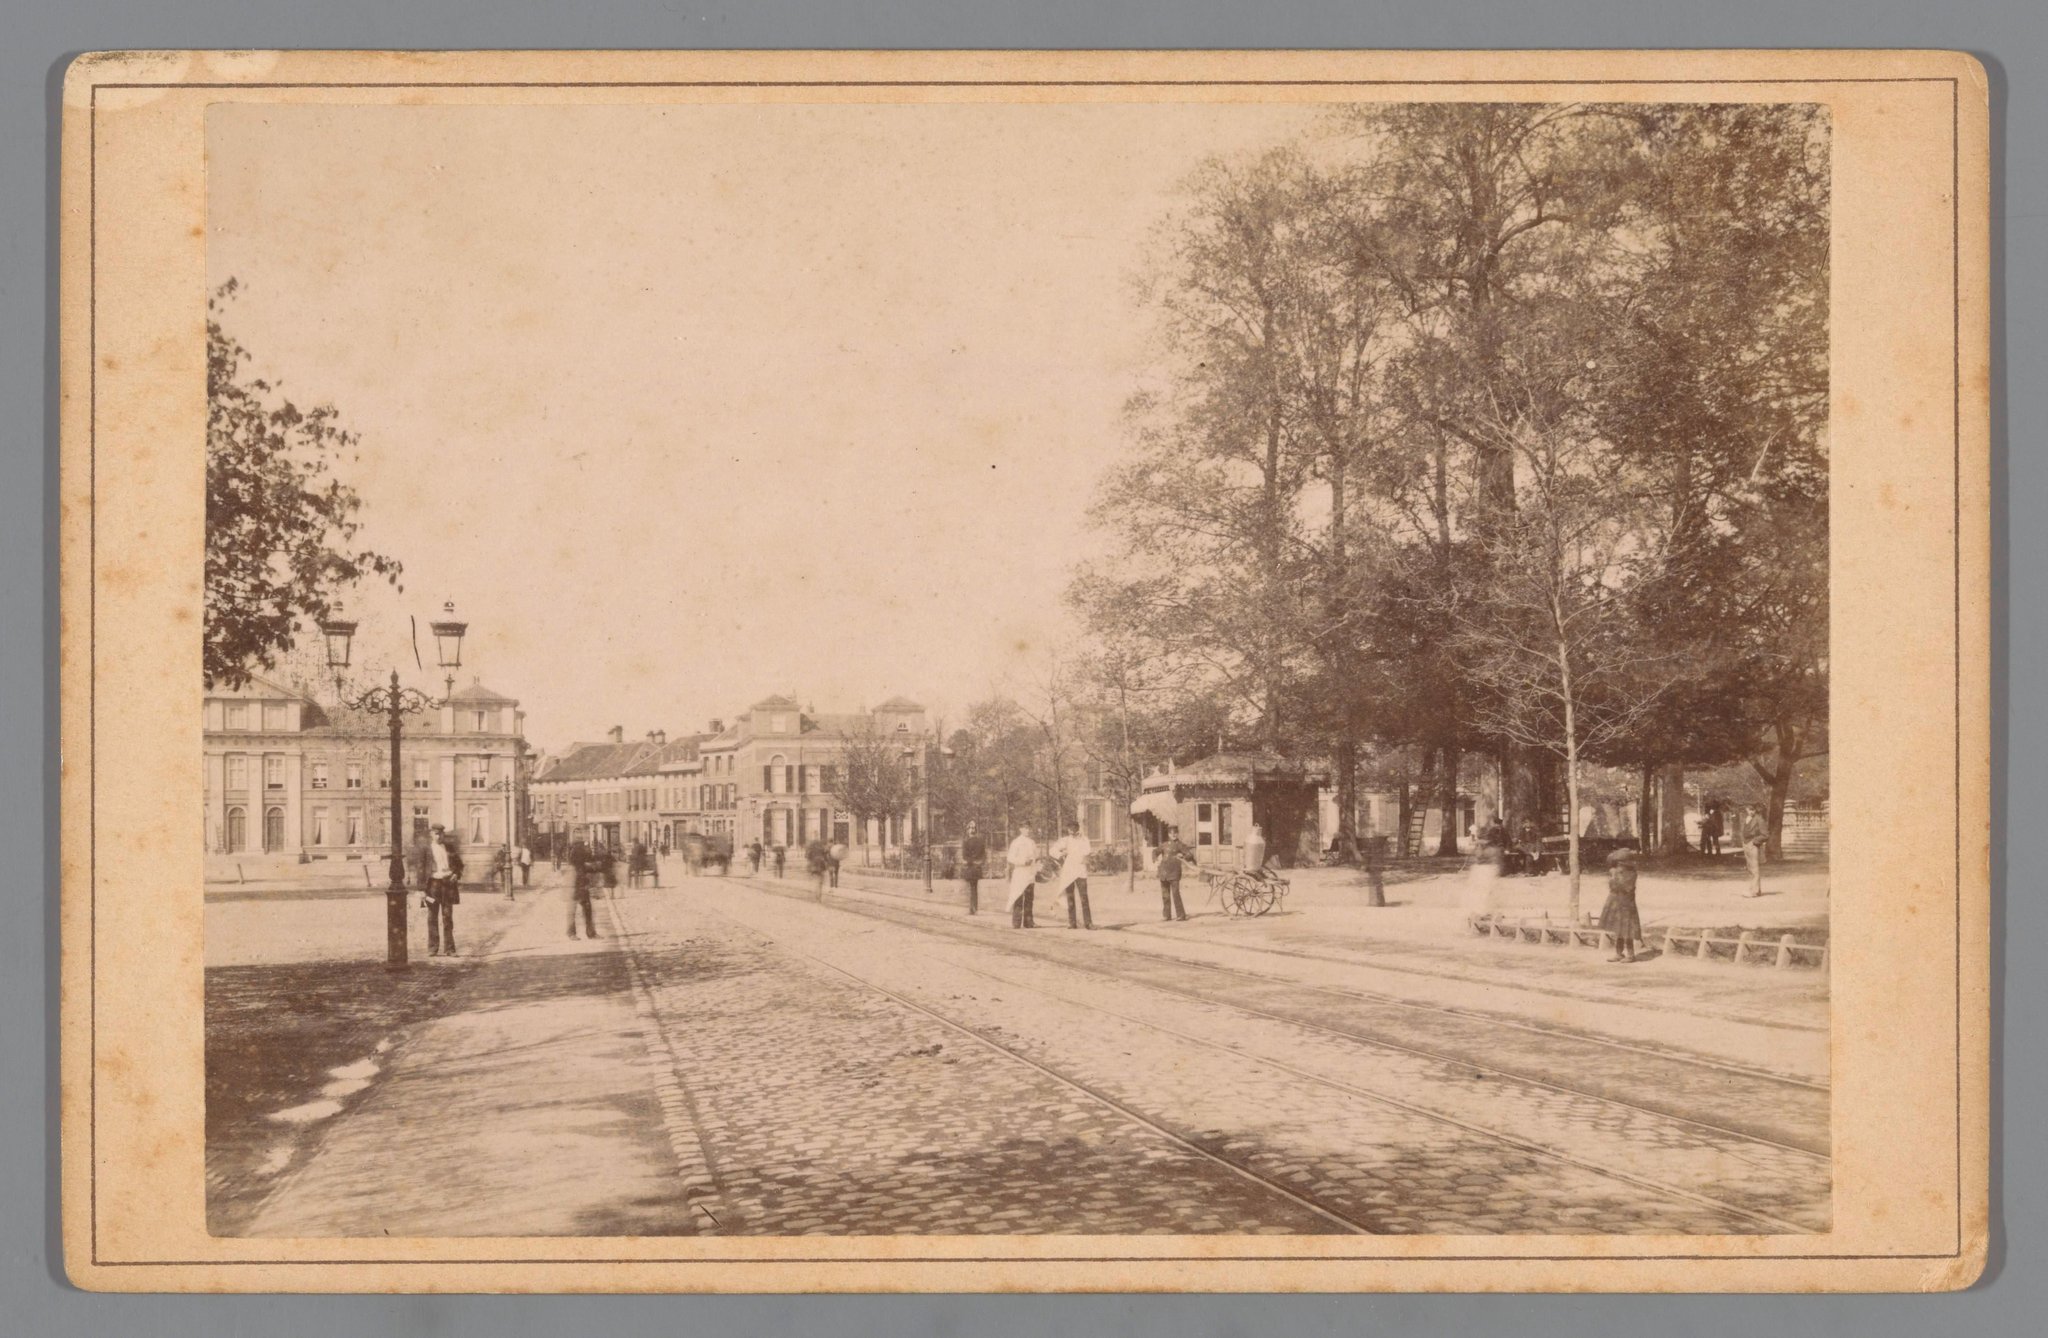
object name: cabinet photograph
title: Gezicht op het Velperplein in Arnhem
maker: j.s.j. de jongh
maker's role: fotograaf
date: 1850-1900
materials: cardboard, photographic support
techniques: albumen print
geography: arnhem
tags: square, place, circus, etc.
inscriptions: inscription: ‘Velperplein. Arnhem./ J. S. J. DE JONGH W.Jzn., Koningstraat 84-85. ARNHEM.’